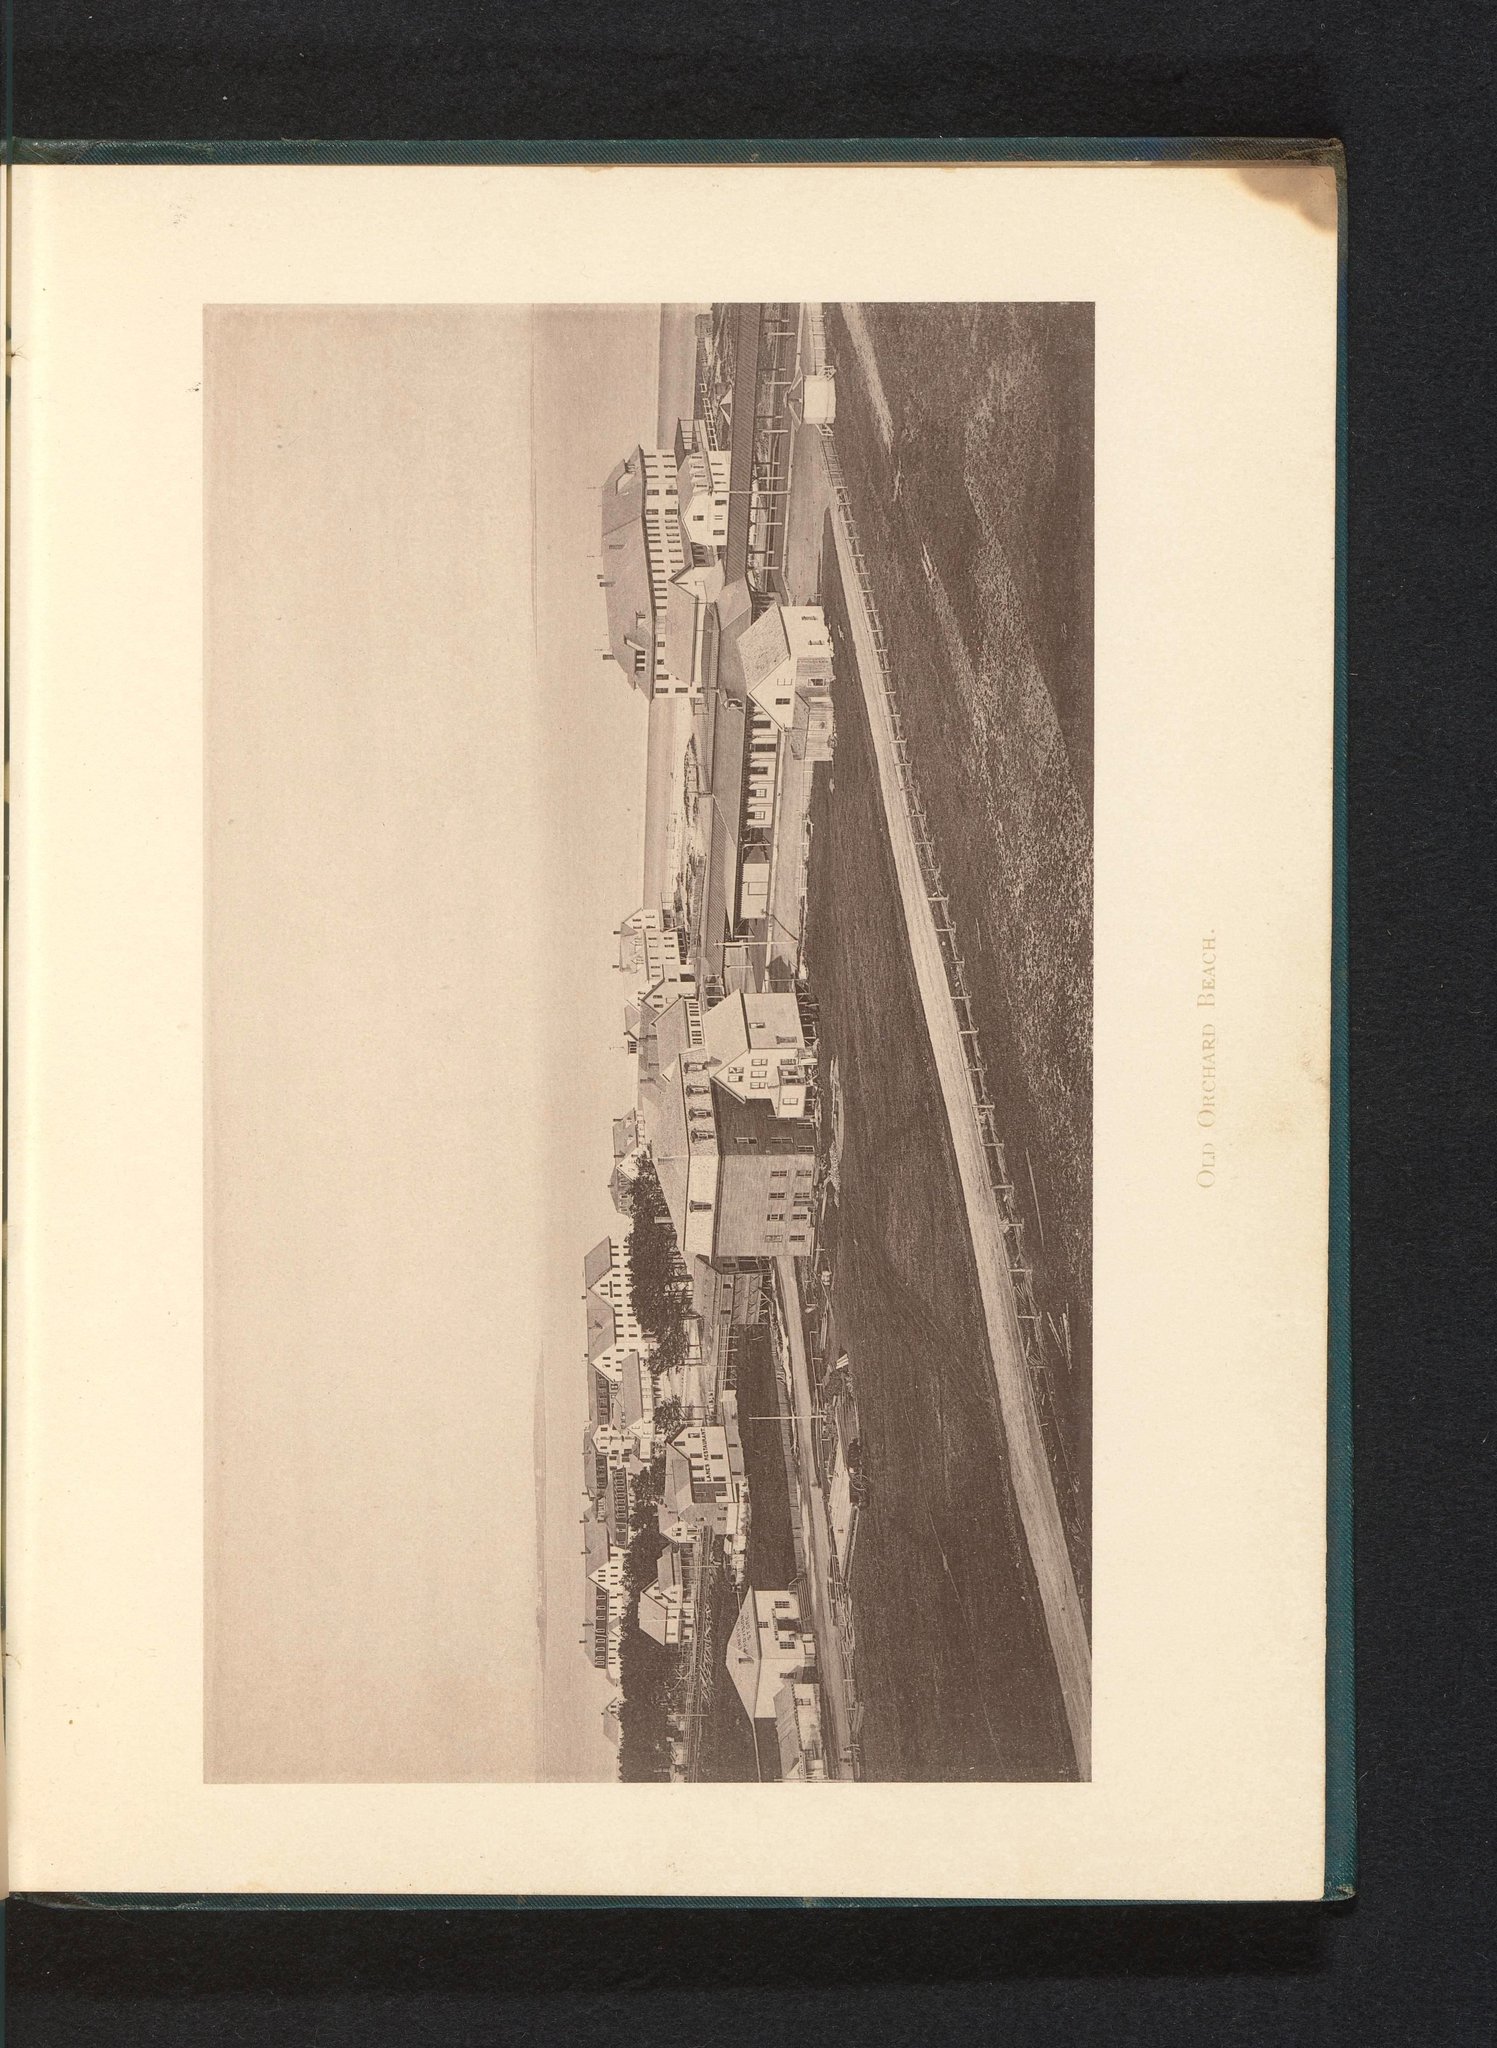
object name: photomechanical print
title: Gezicht op Old Orchard Beach in Maine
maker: Anonymous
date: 1875-1880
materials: paper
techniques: photograph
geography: old orchard beach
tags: city-view, and landscape with man-made constructions, beach